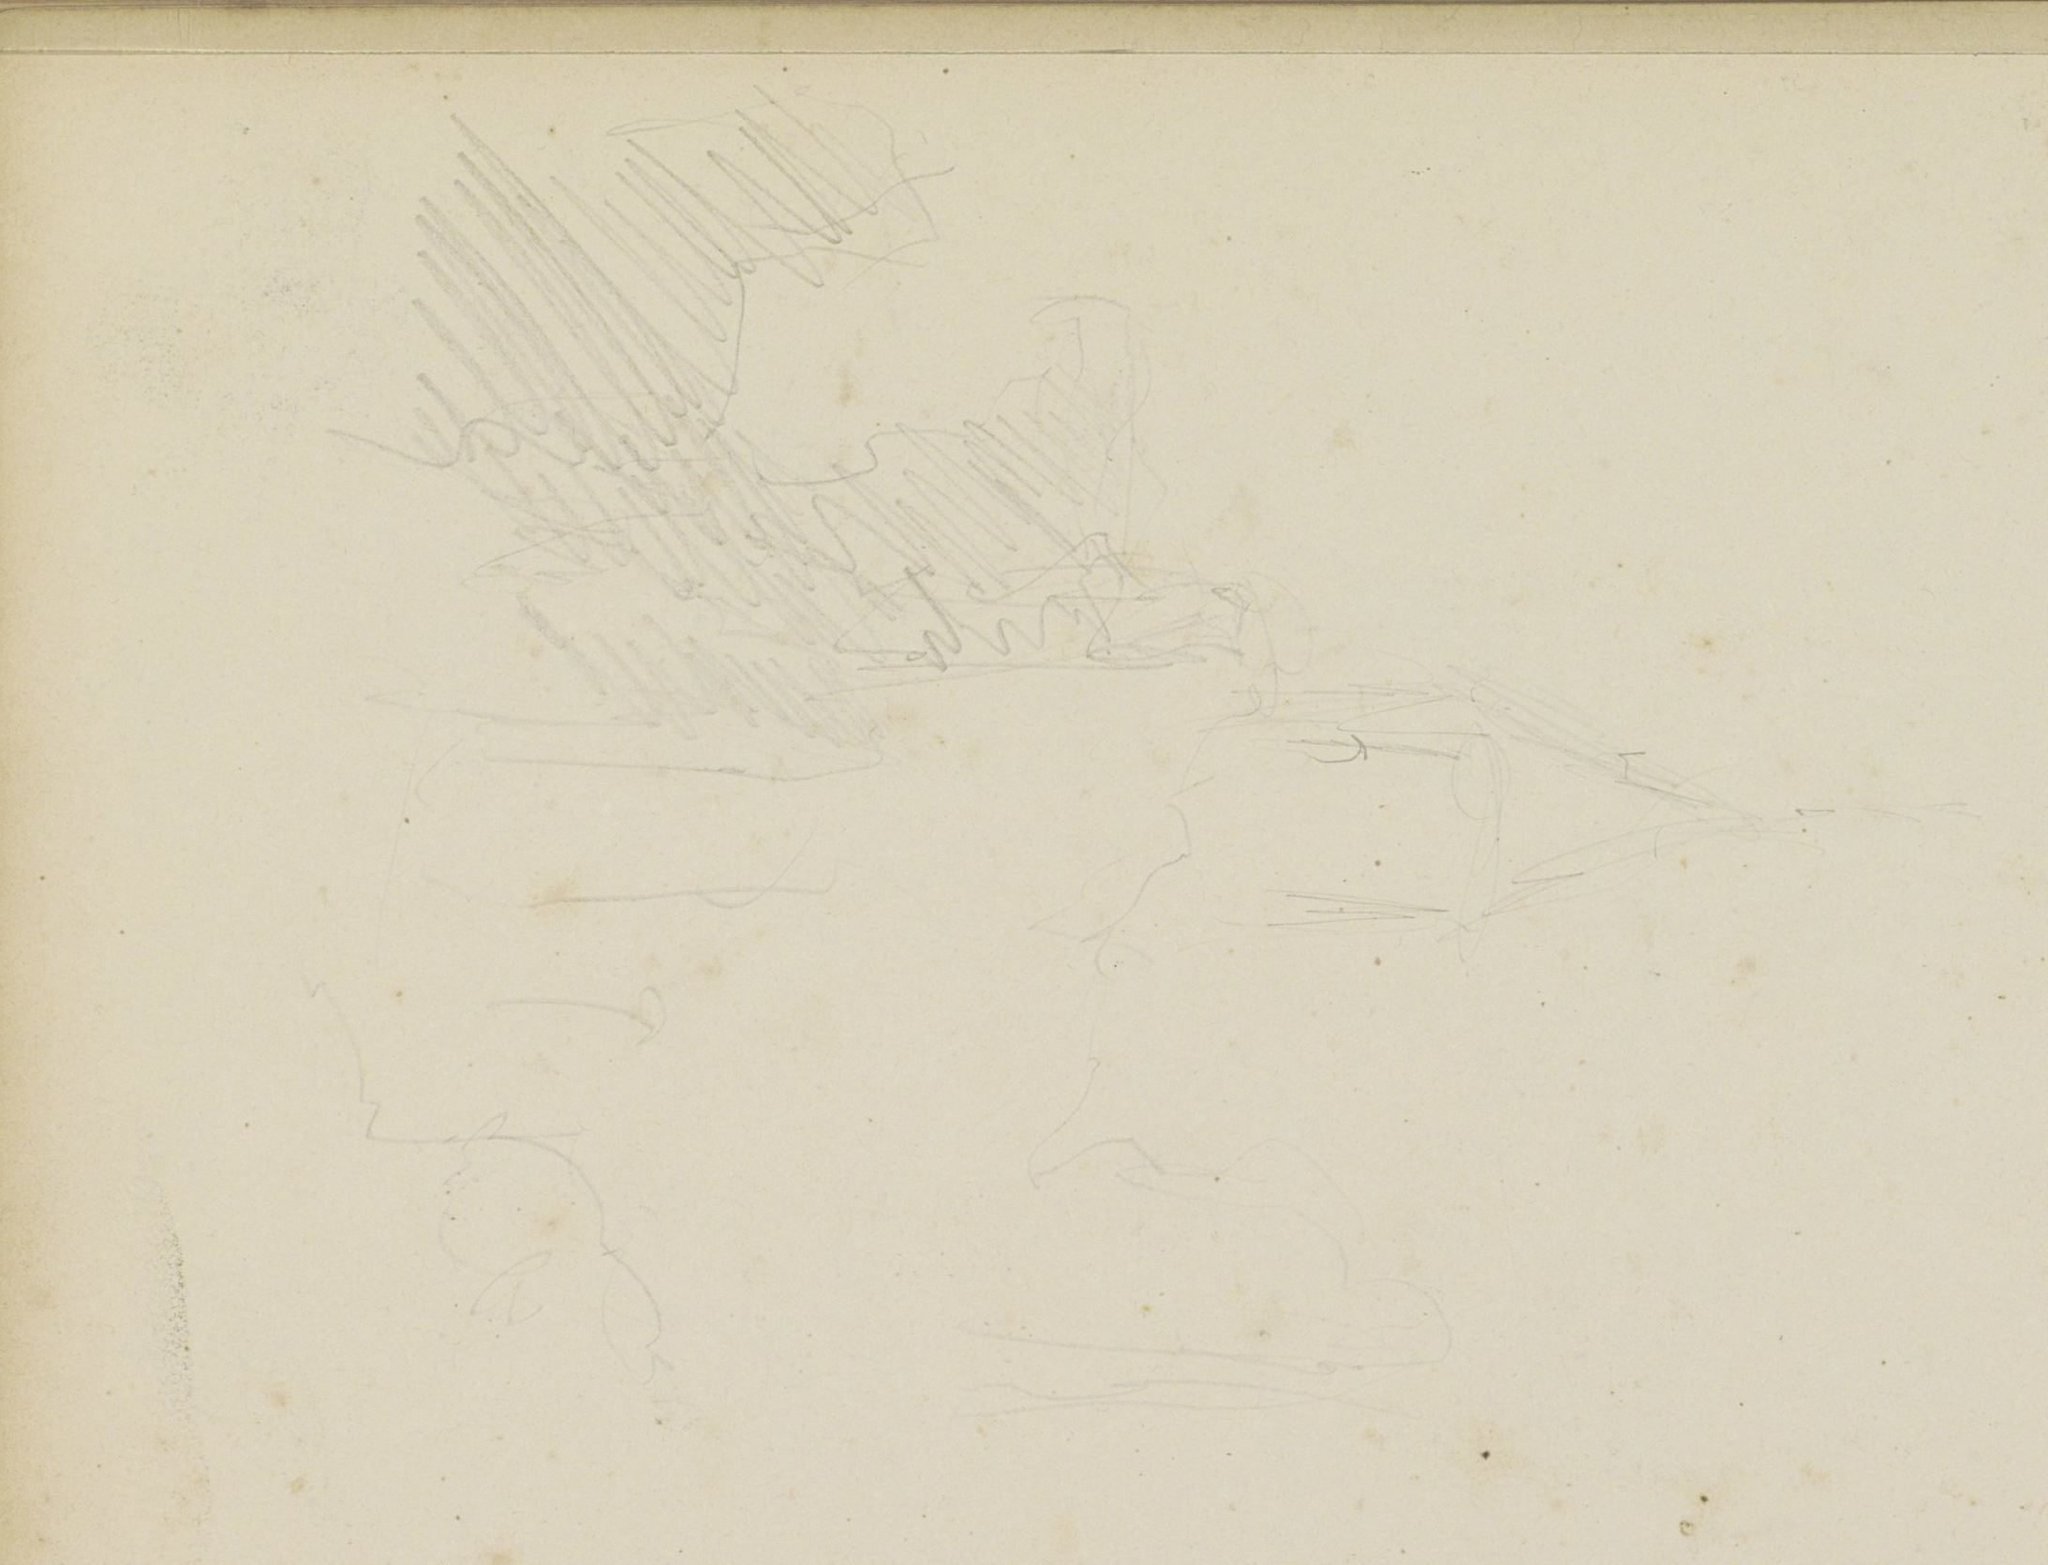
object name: sketchbook leaf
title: Gezicht op een gebouw met een toren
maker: adrianus eversen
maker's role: draughtsman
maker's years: 1818-1897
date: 1828-1897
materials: paper, pencil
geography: netherlands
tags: city-view, and landscape with man-made constructions, tower (of house or building)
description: Gezicht op een gebouw met een toren. Blad 18 verso uit een schetsboek met 41 bladen.